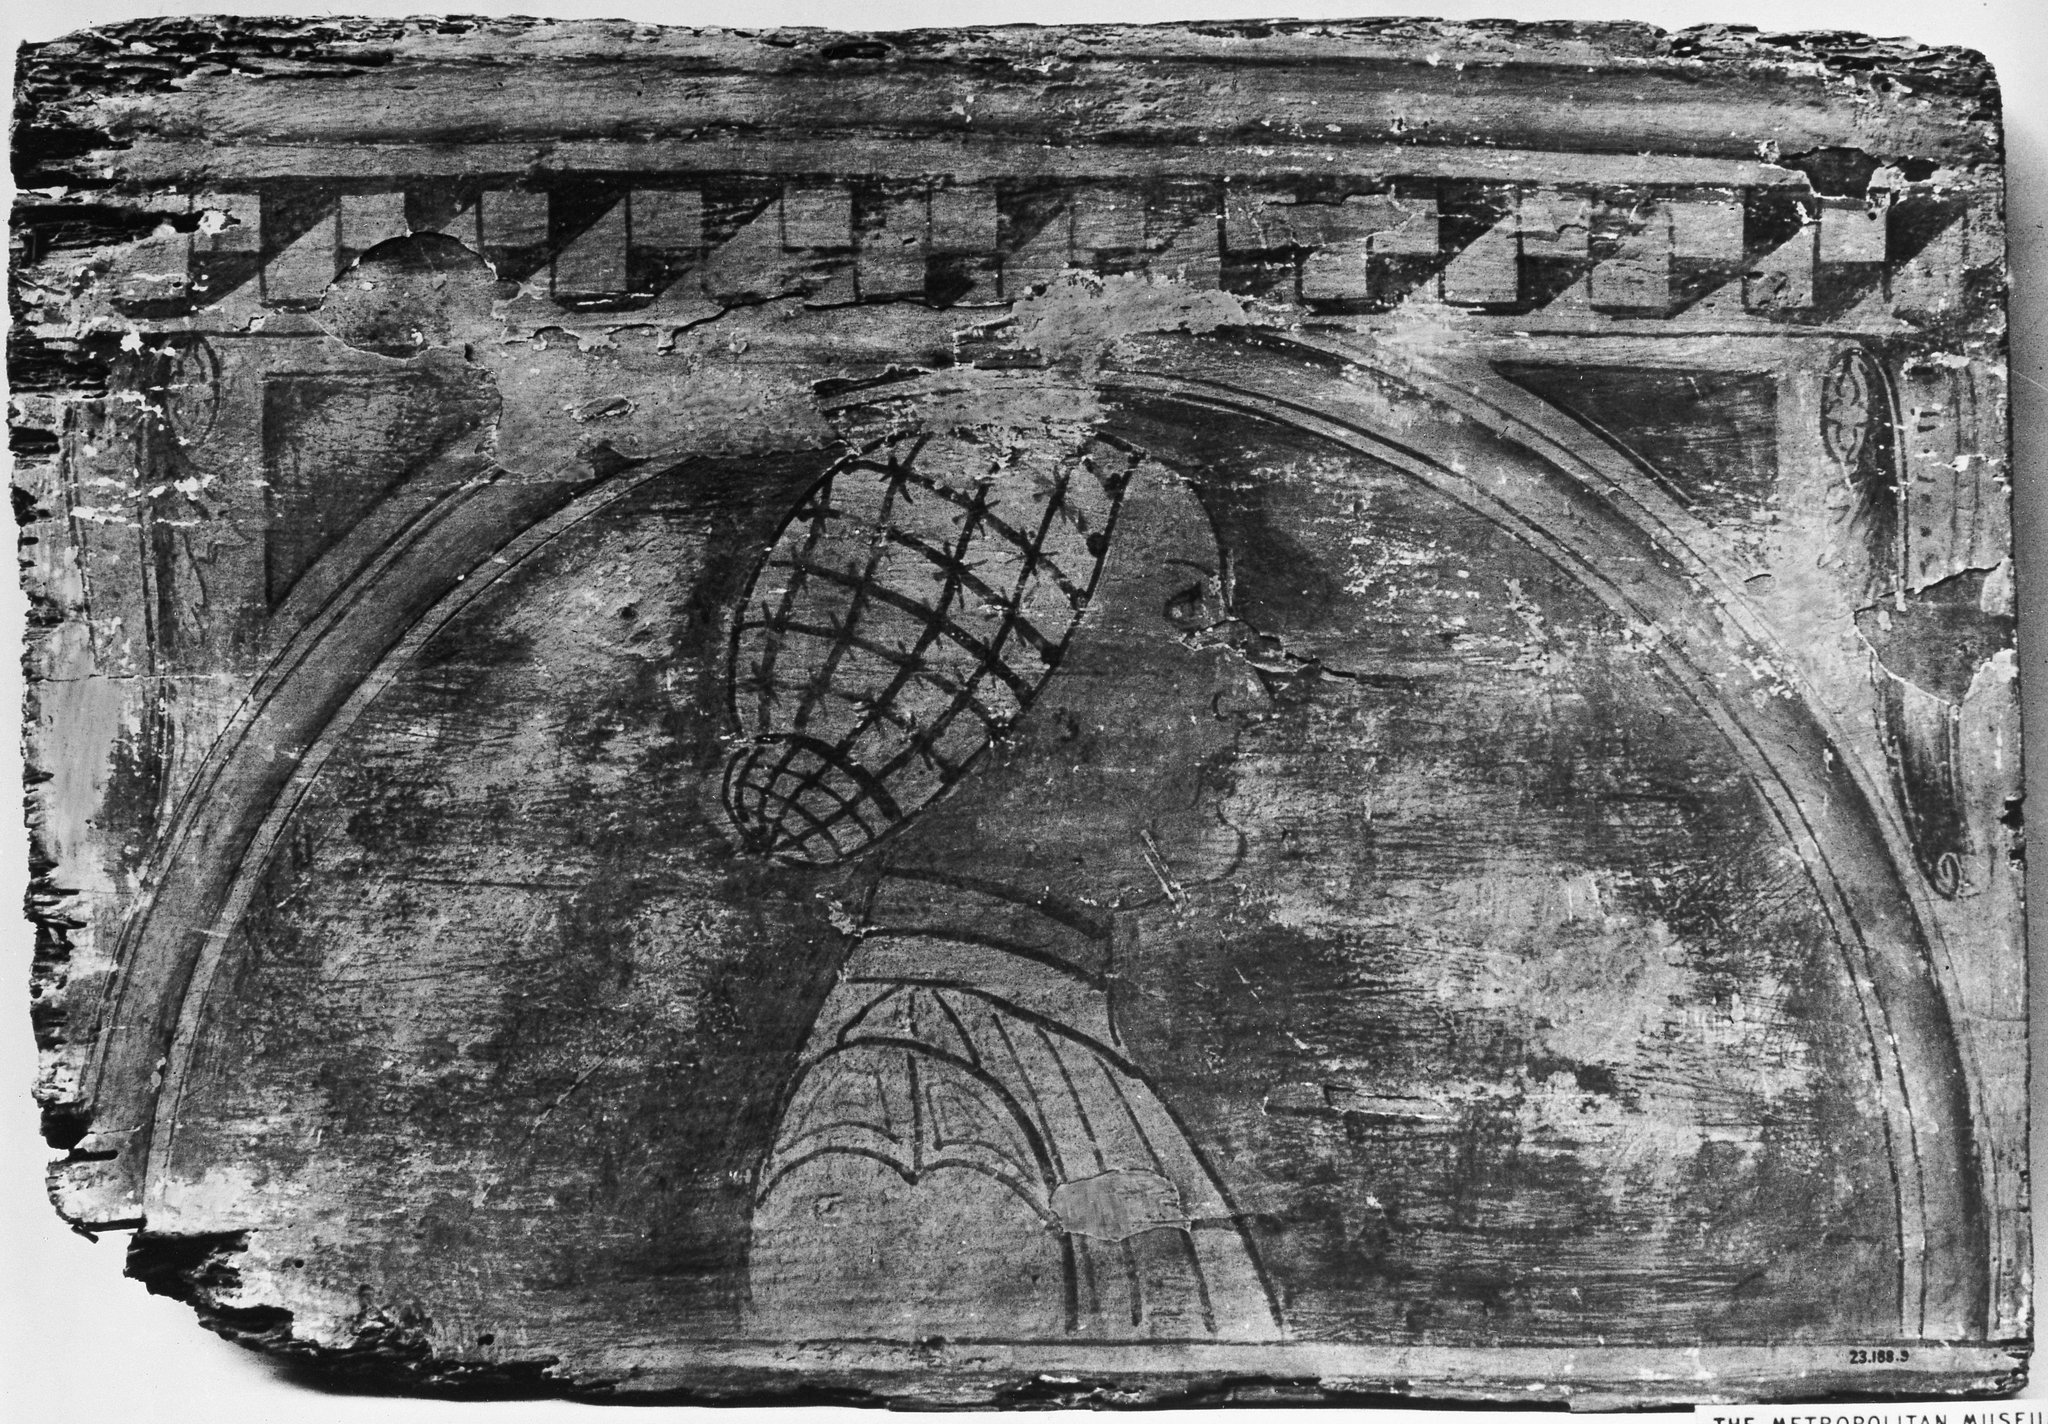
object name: frieze panel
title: Head of a woman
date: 1501-1533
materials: paint, wood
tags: profiles,women